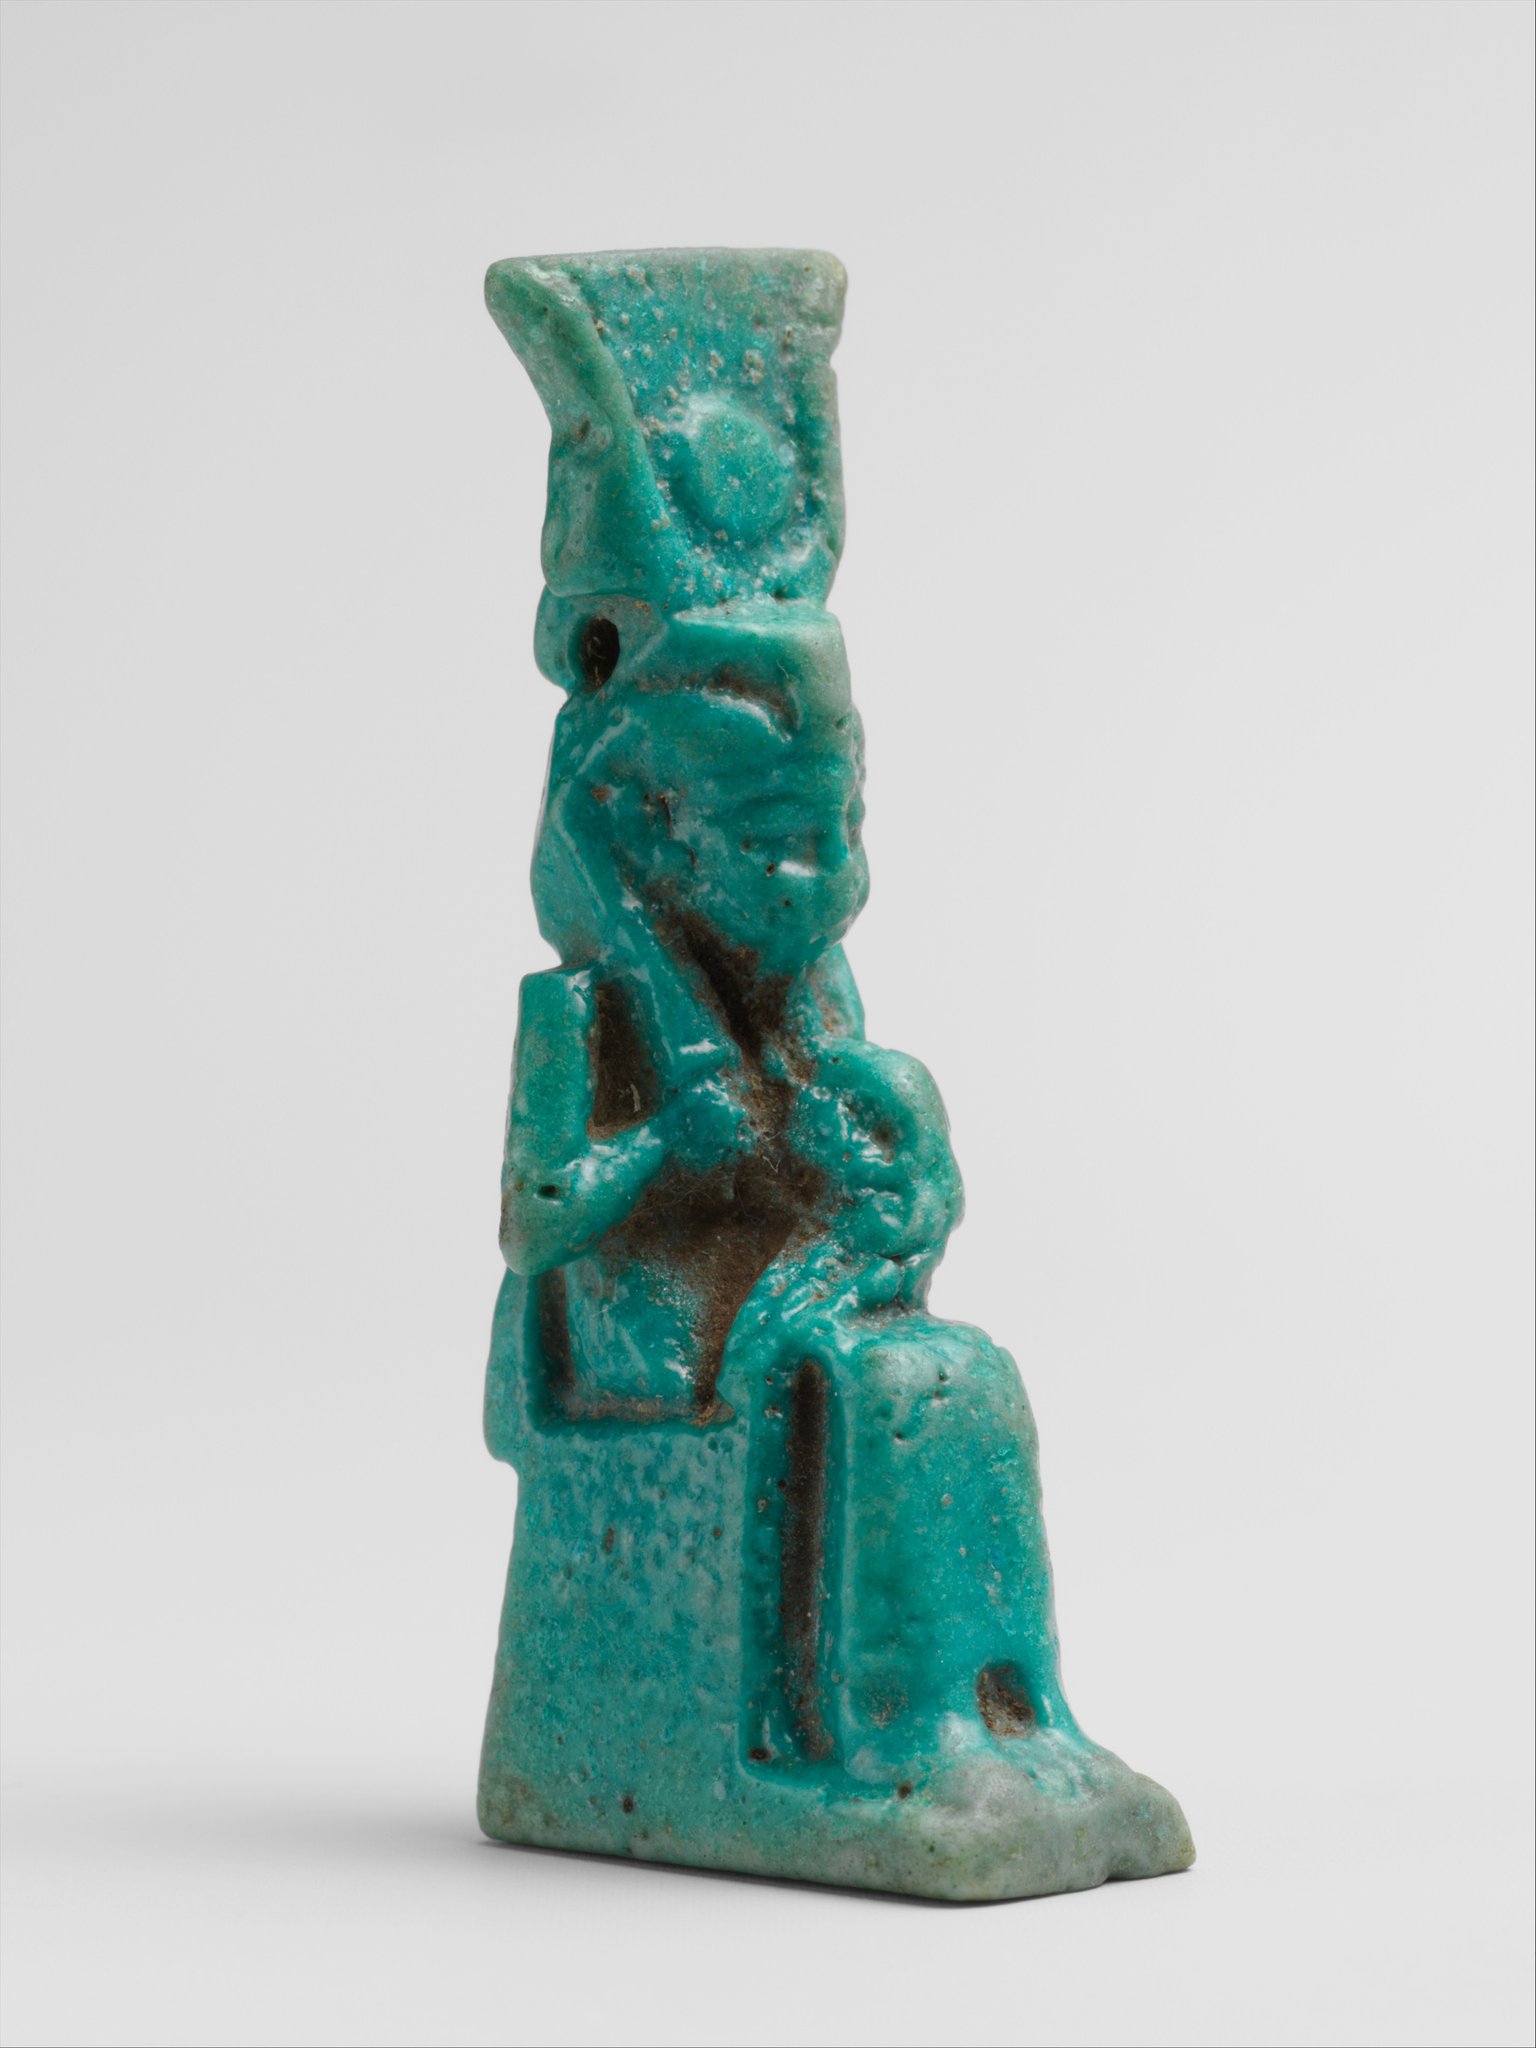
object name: amulet, isi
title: Faience amulet of Isis and Horus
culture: egyptian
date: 664-334 BCE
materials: faience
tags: horus,isis